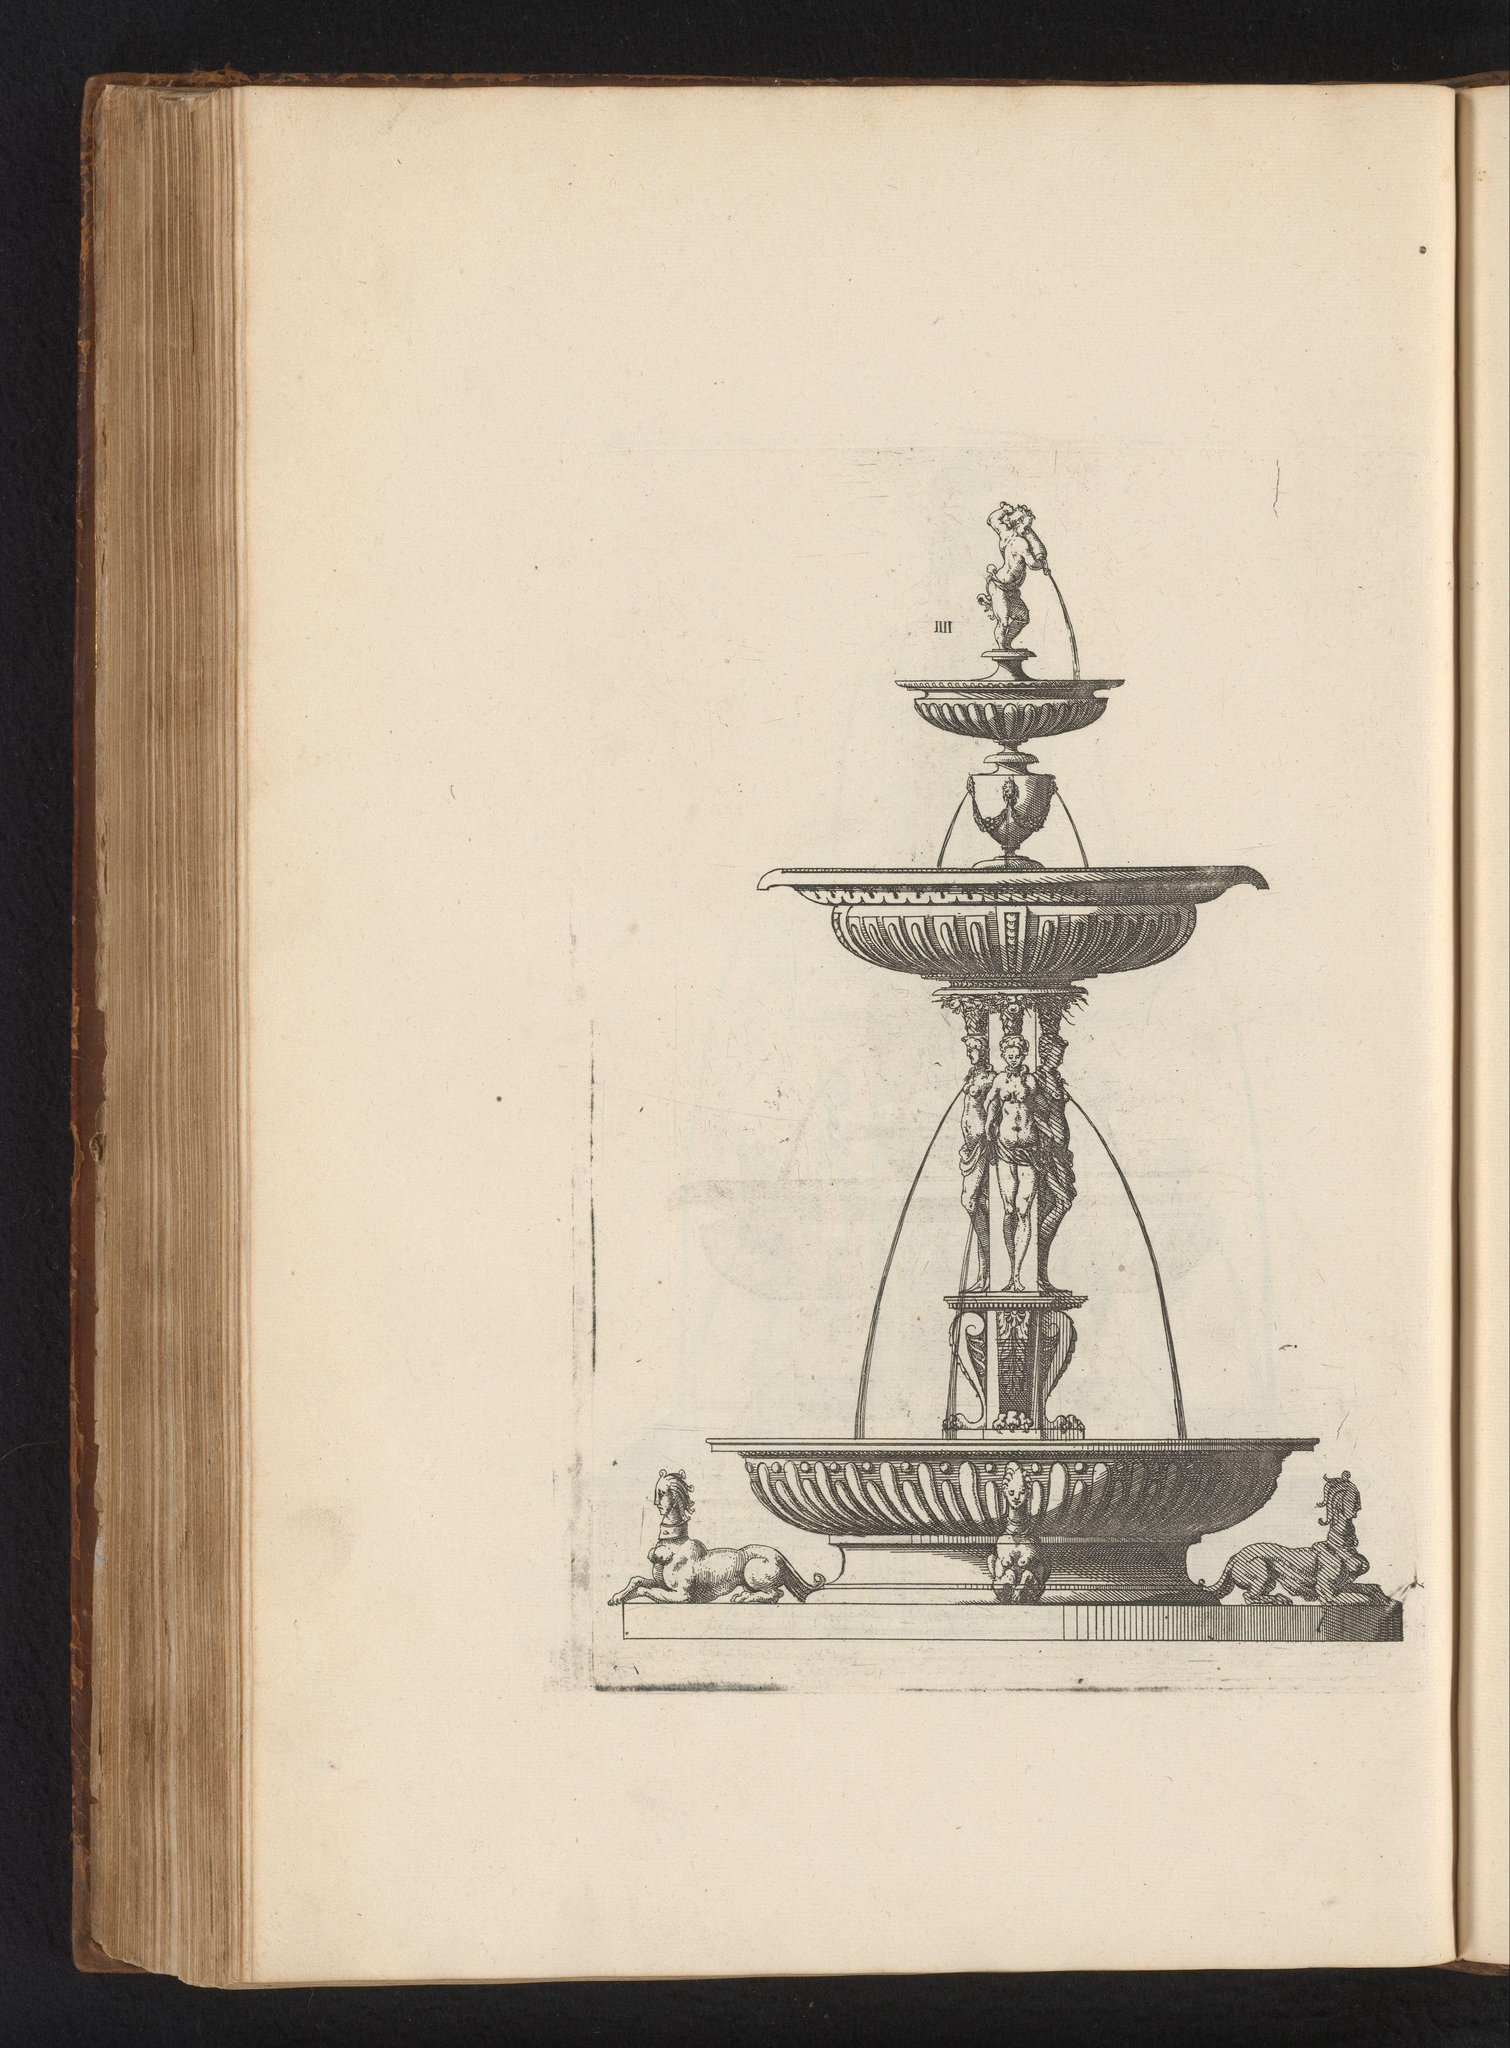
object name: ornament print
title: Fontein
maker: jacques androuet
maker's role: draughtsman, print maker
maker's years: 1515-1584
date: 1561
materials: paper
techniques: etching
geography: paris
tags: garden fountain, ornamental fountain, architectural design or model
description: Fontein in drie etages, met schalen, vrouwenfiguren en sfinxen. Onderdeel van 'Seconde livre d'architectvre' (1561): 64 etsen met geornamenteerde architectuuronderdelen.